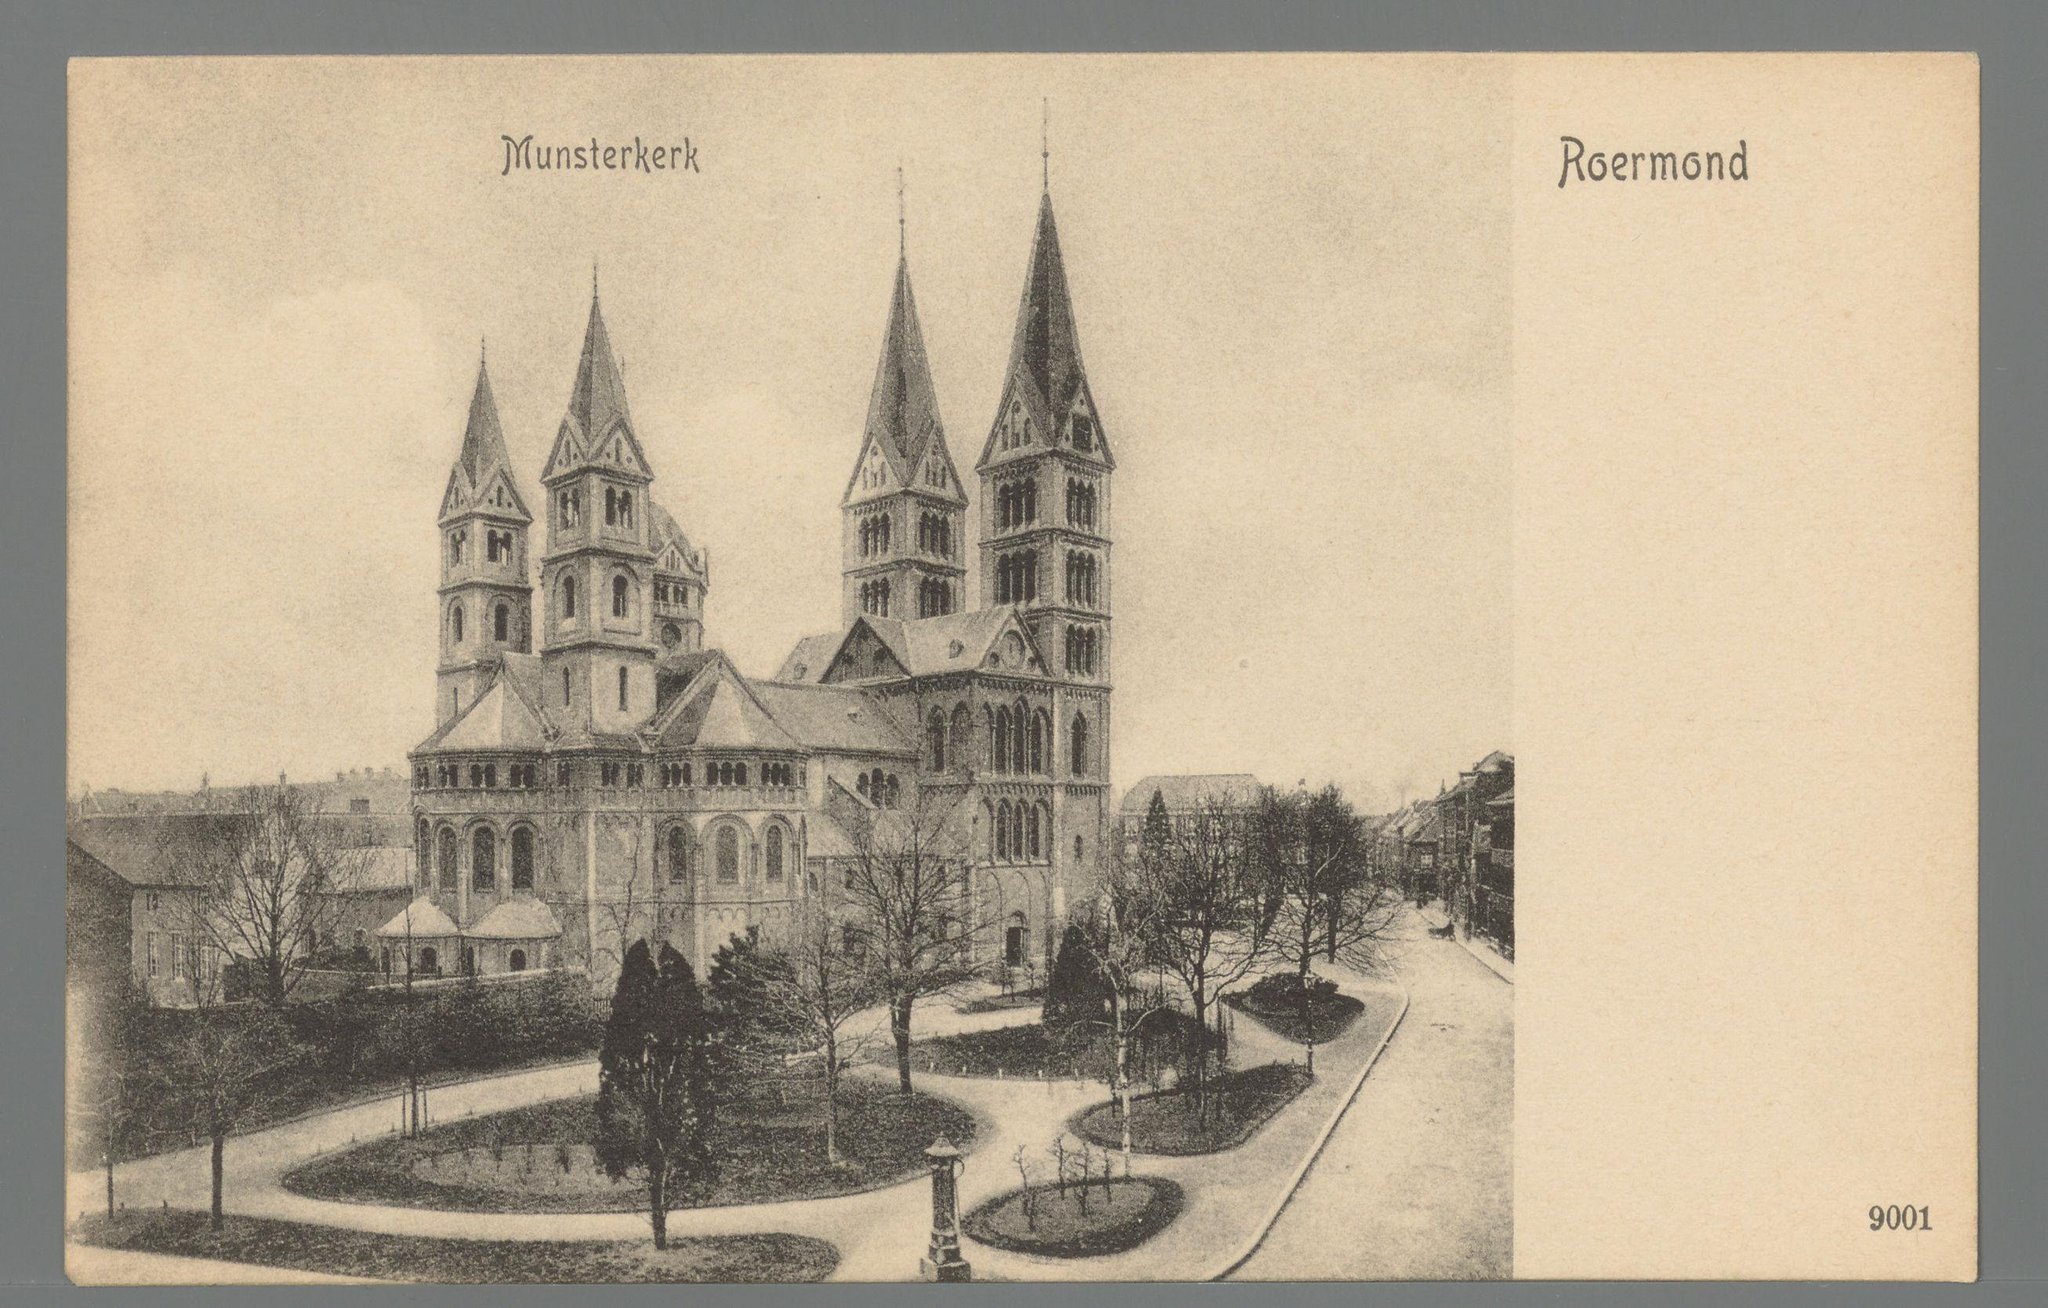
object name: ansichtkaart, prentbriefkaart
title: Munsterkerk. Roermond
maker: Anonymous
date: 1897-1905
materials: cardboard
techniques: photograph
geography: roermond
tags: park, church (exterior)